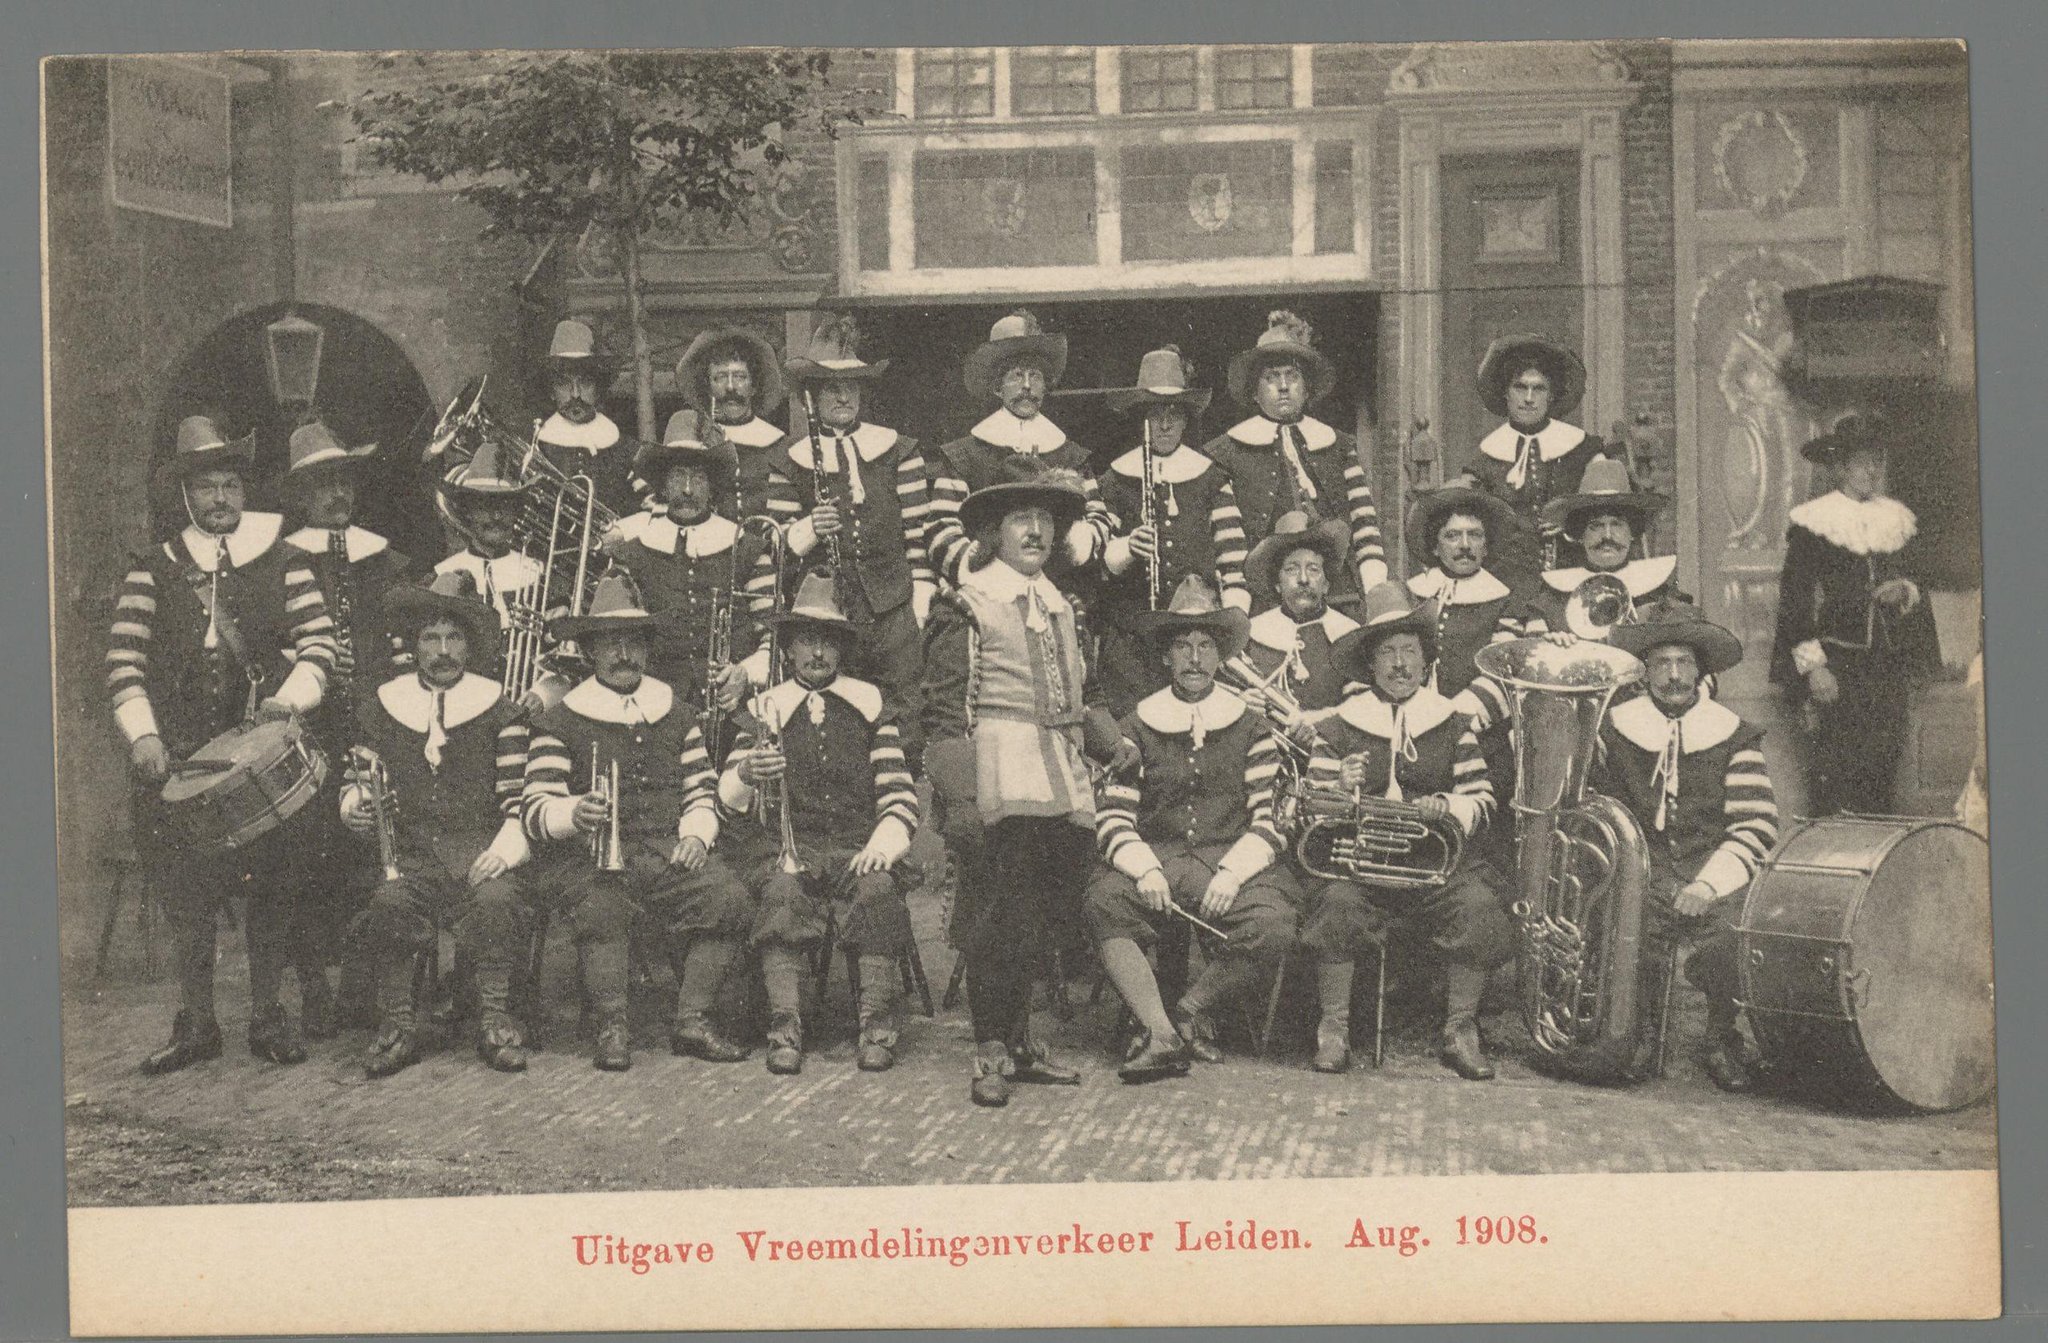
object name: ansichtkaart, prentbriefkaart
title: Groepsportret van musici in kostuum tijdens de Oud-Hollandse feesten te Leiden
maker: Anonymous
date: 1908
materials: cardboard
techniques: photograph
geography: haarlem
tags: dress-up party, festivities, anonymous historical persons portrayed in a group, in a group-portrait, leiden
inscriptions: date